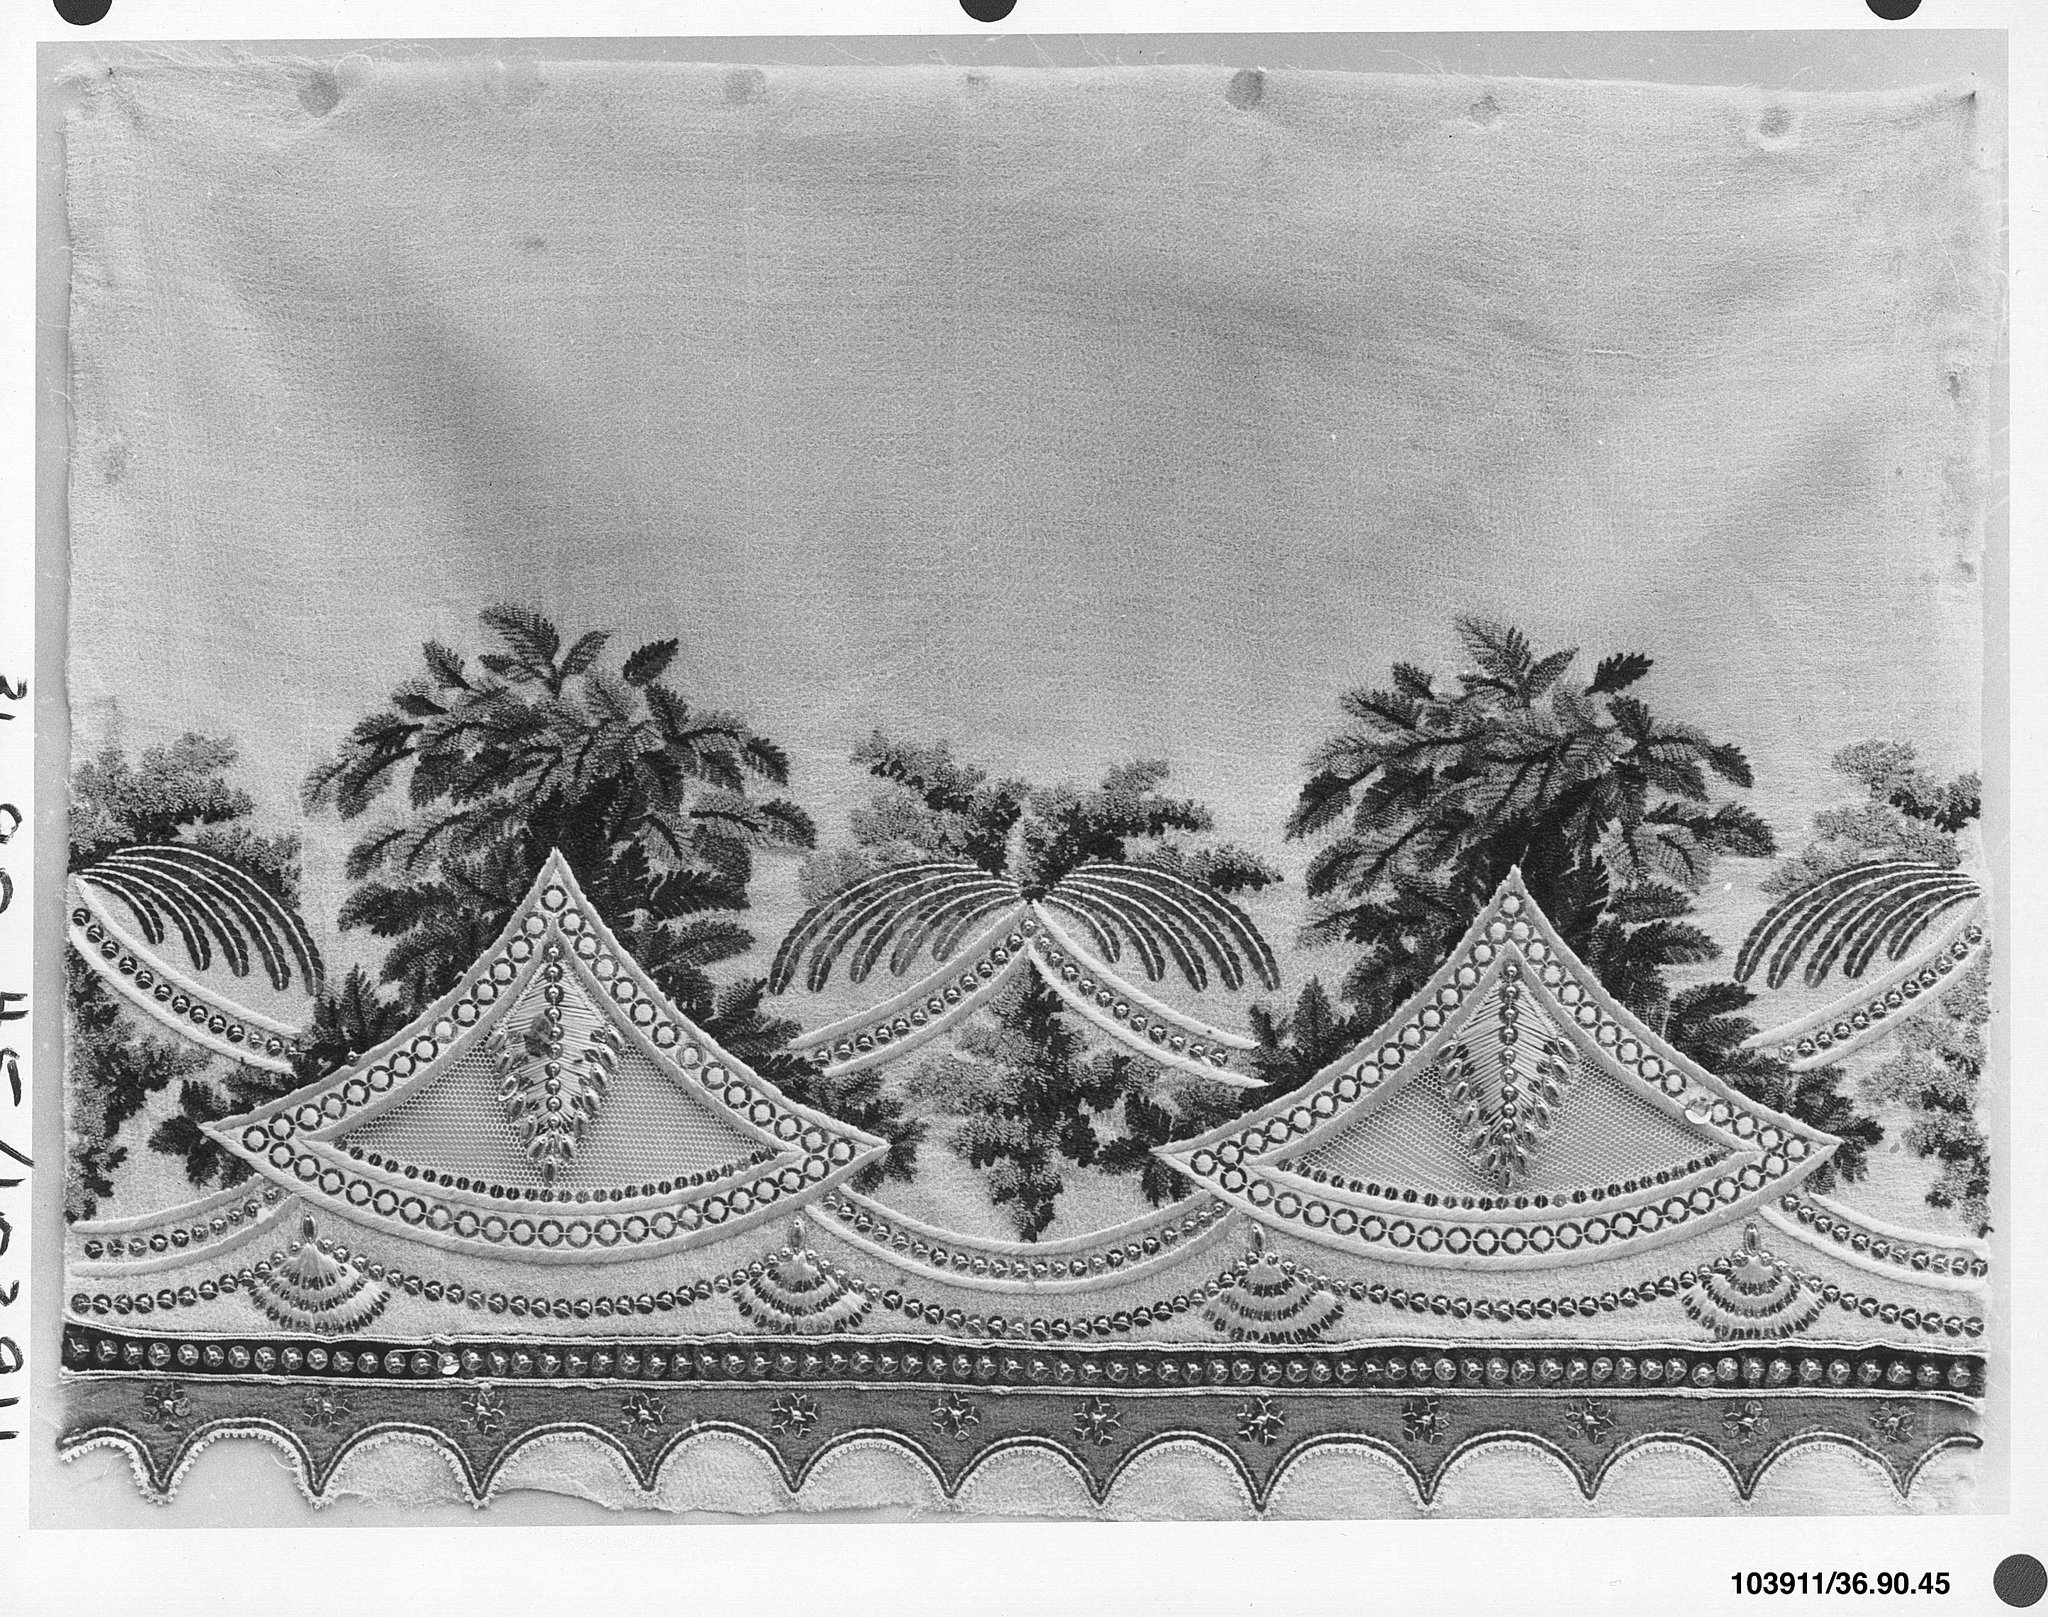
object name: border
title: Dress border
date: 1801-1833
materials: metal thread, silk